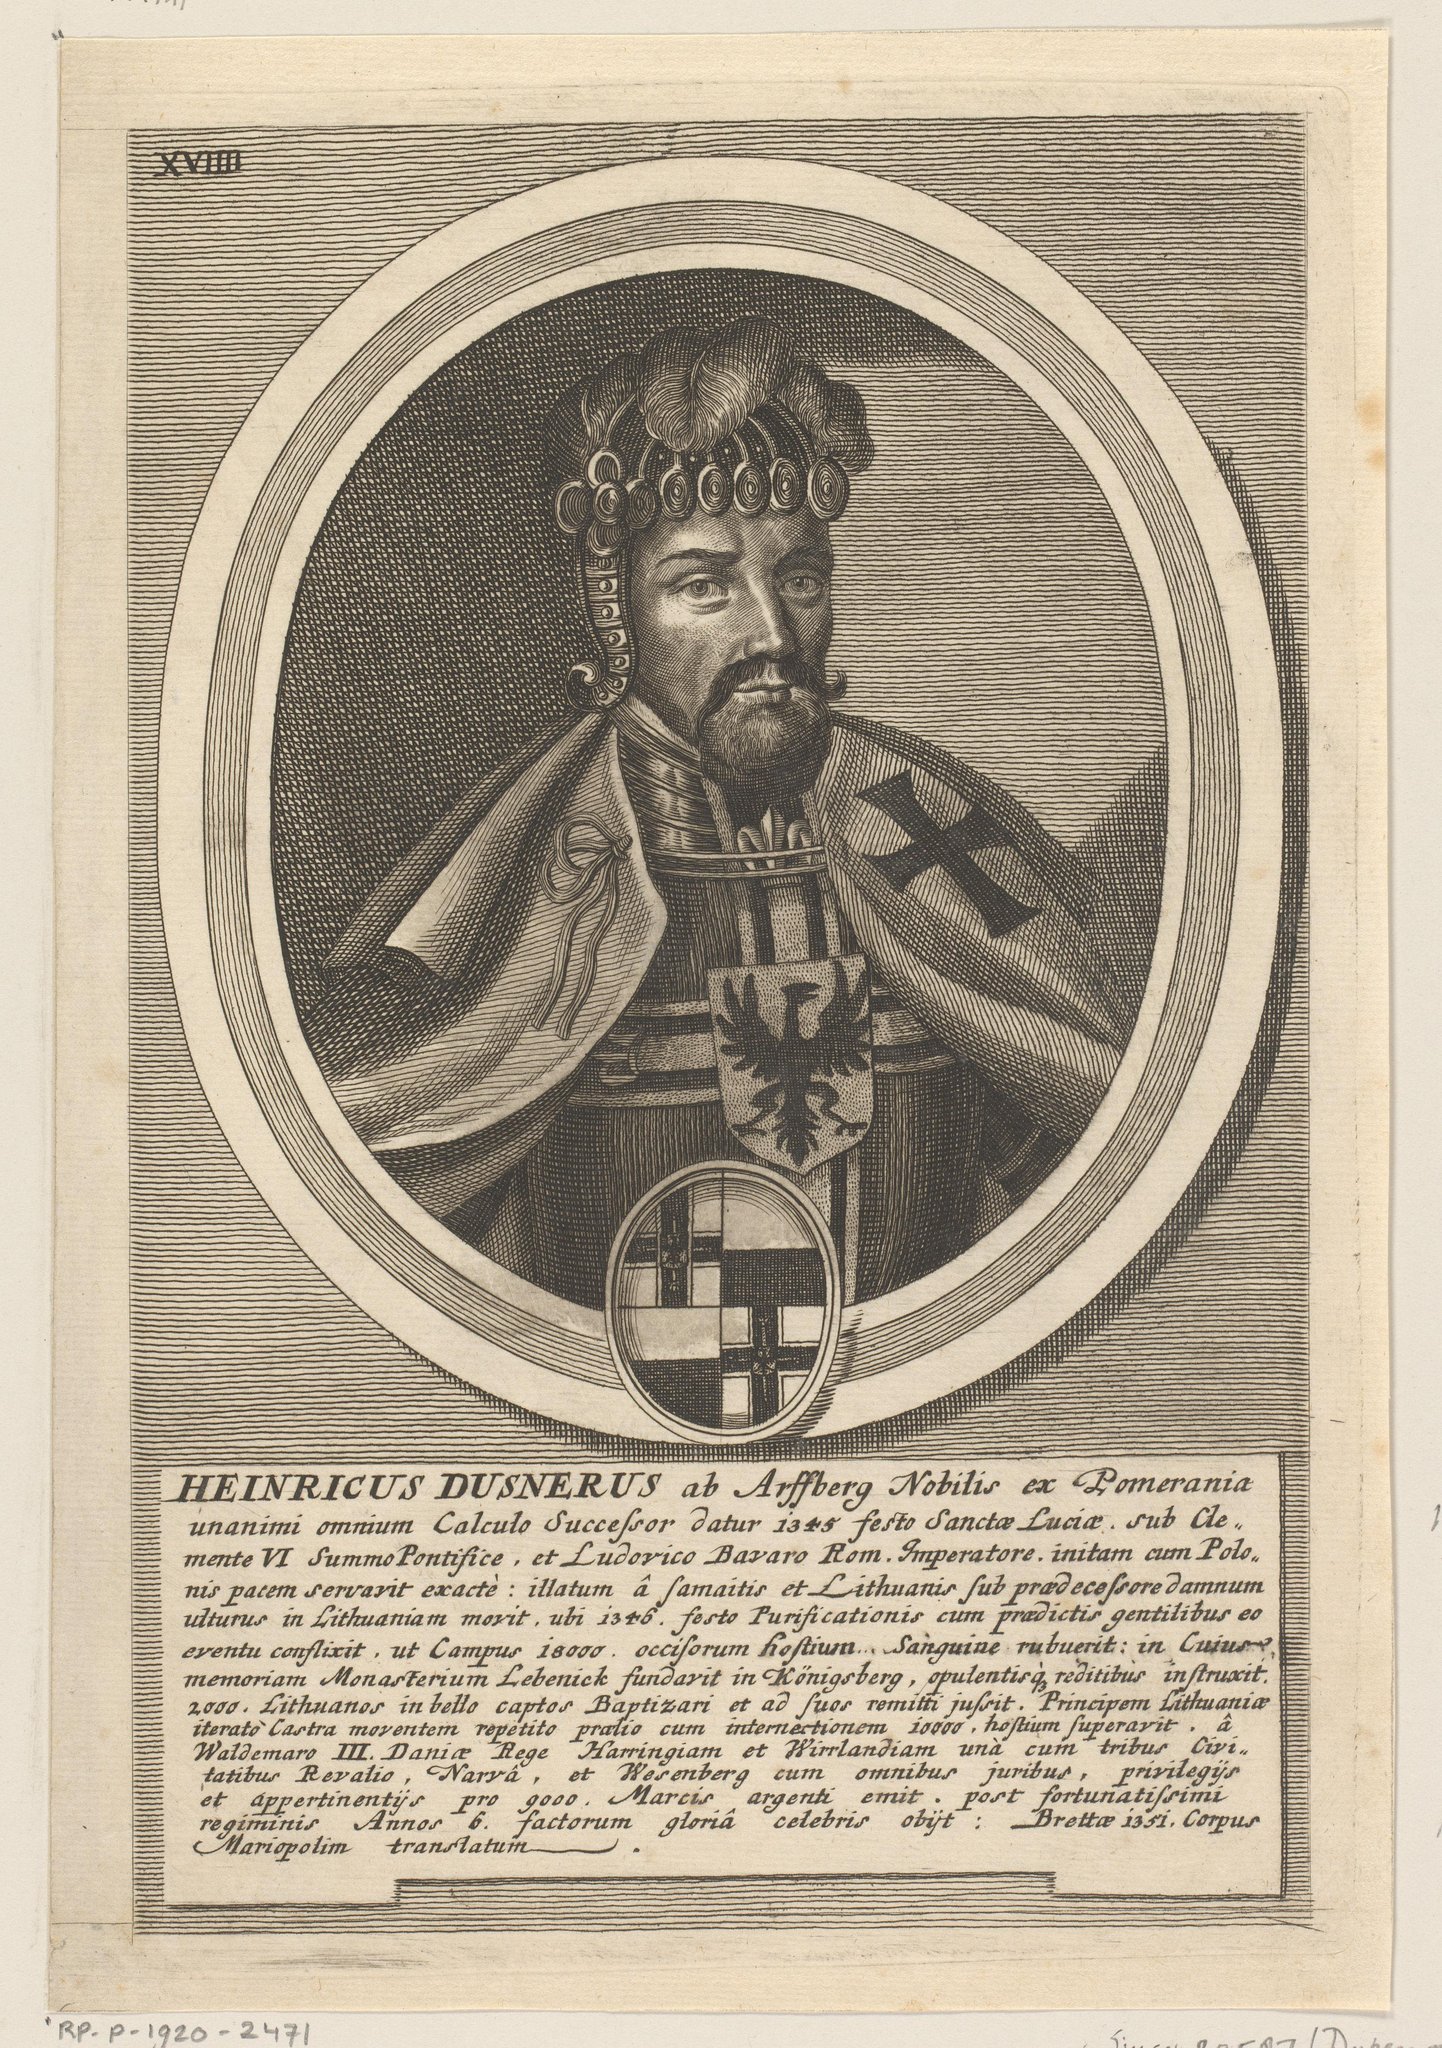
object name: print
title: Heinricus Dusnerus ab Arffberg (...)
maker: johann salver (i)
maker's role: print maker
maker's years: 1670-1738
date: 1720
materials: paper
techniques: engraving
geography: würzburg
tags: knighthood order: teutonic order - insignia of a knighthood order, e.g.: badge, chain (with name of order), historical persons, armorial bearing, heraldry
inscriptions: collector's mark: Lugt 2228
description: Prent uit: [Salver, Johann]. De origine, secundis et adversis successibus, nec non de statu moderno inclyti ordinis equestris hospitalis b.m.v. Teutonicorum in Jerusalem. Würzburg: Johann Salver, [ca. 1720].